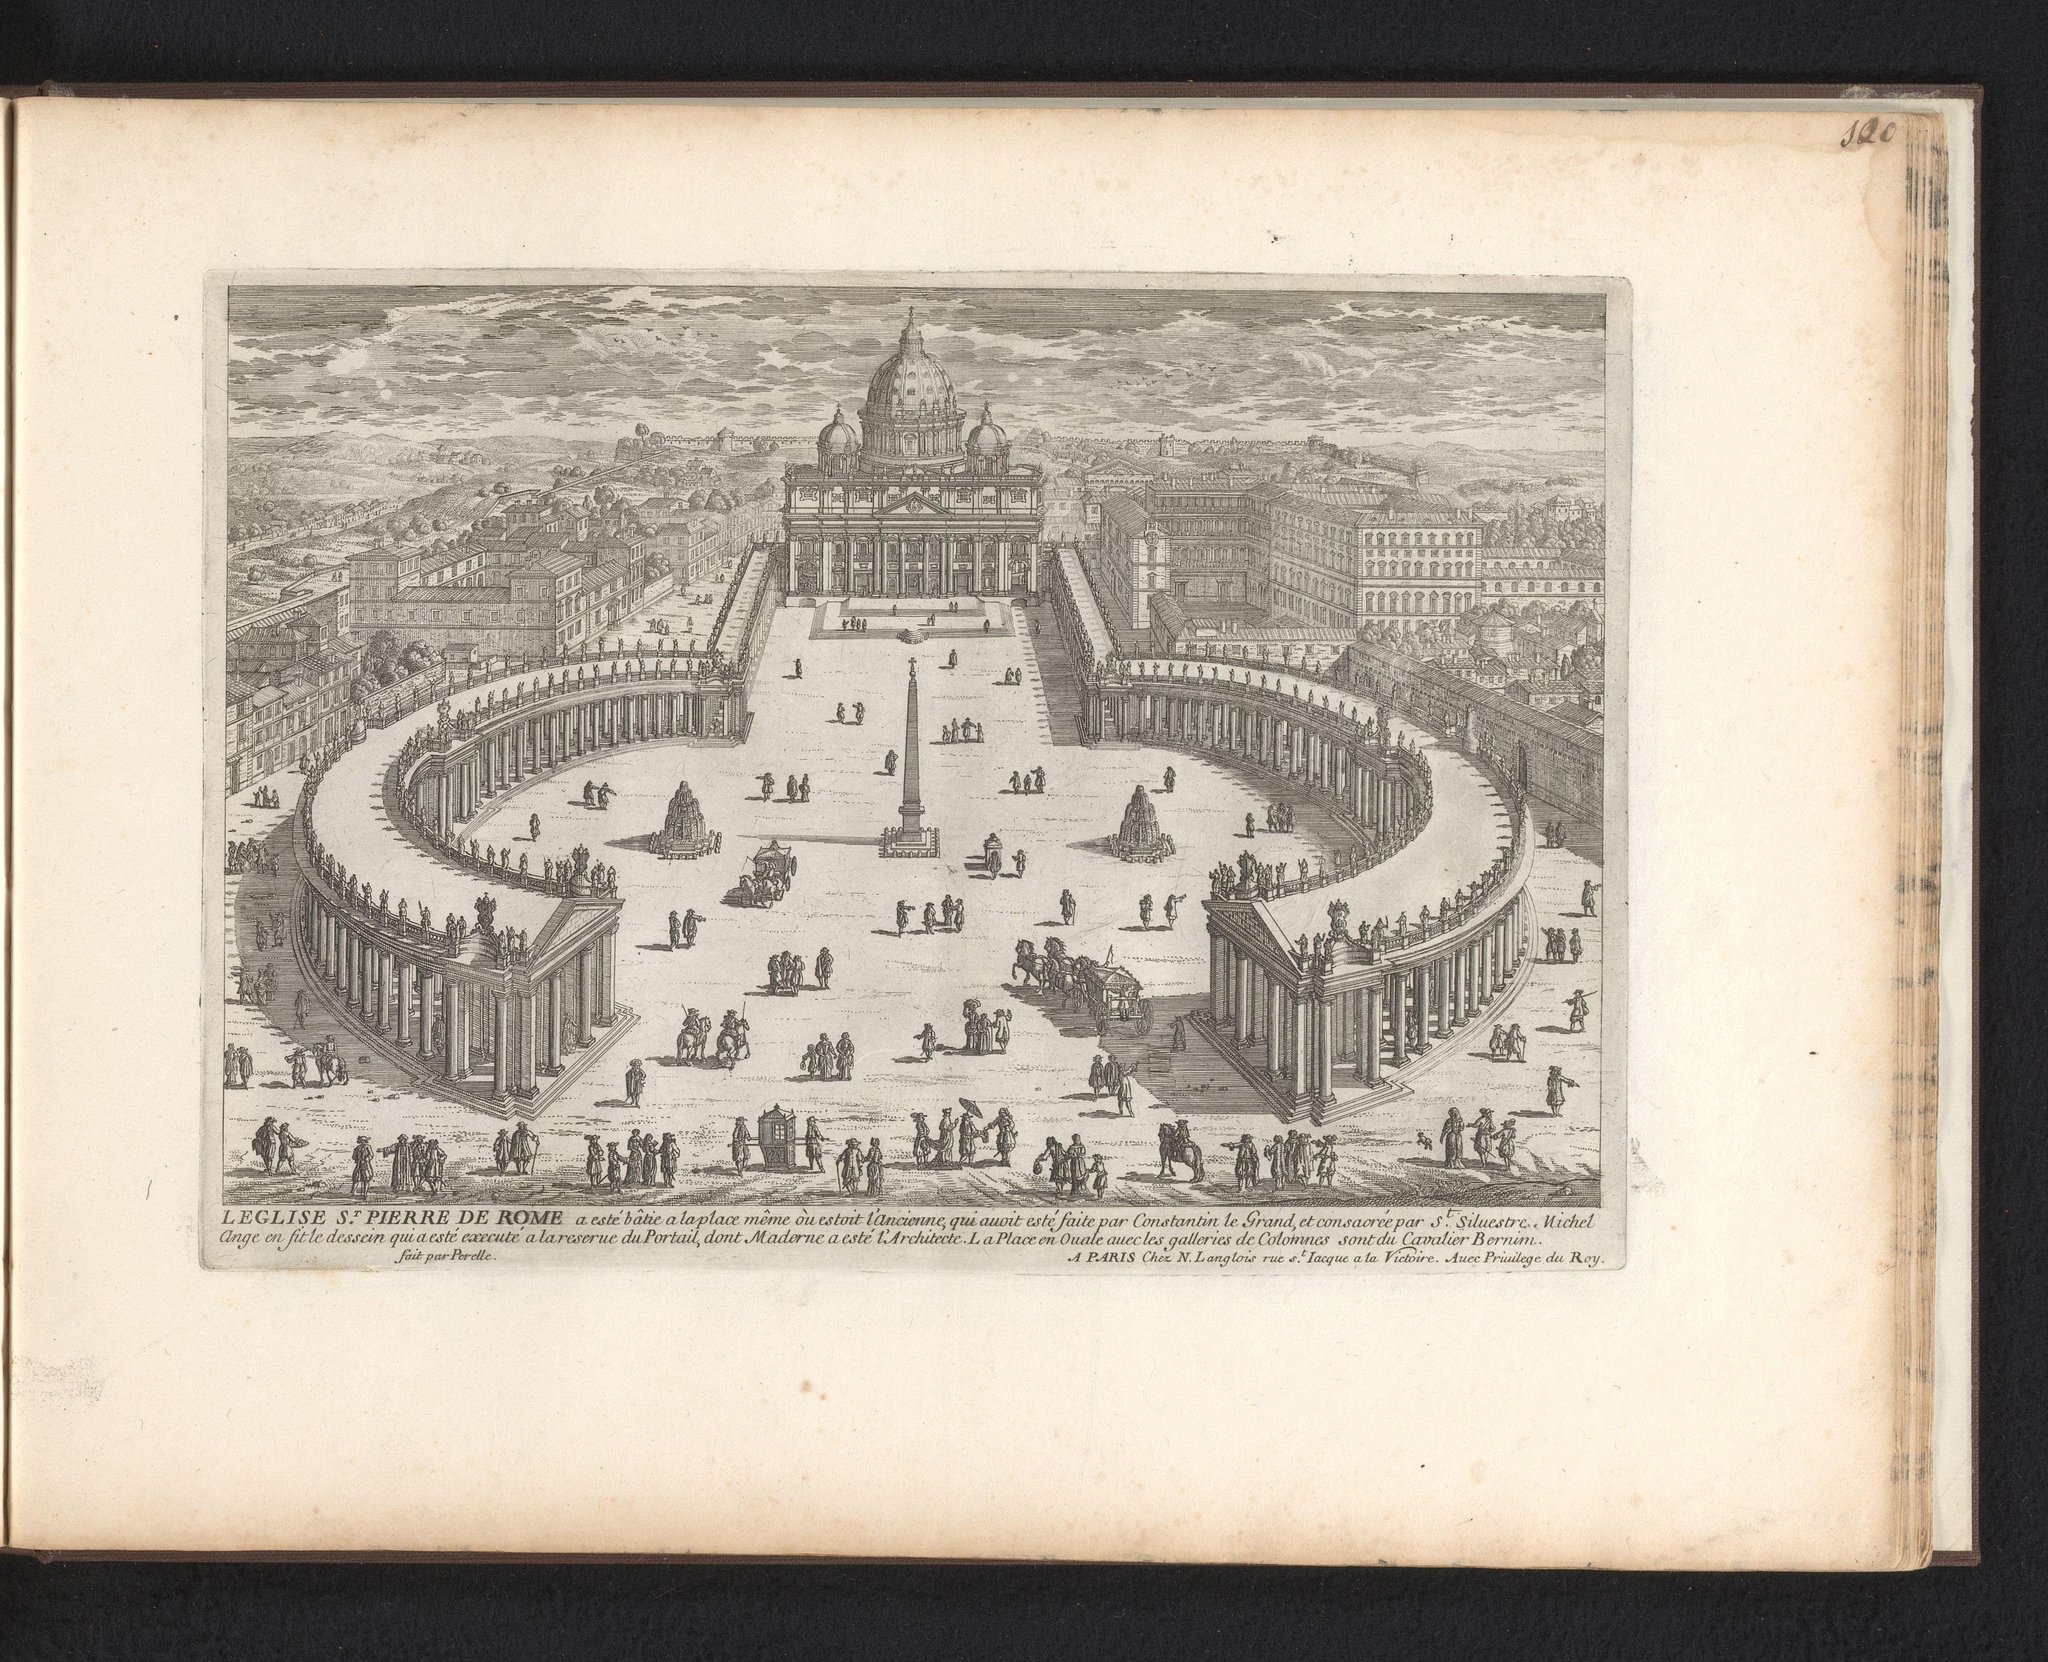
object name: album leaf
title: Stadsgezichten en landschappen in Frankrijk en Italië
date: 1650-1695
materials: paper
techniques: etching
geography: paris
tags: city-view in general; 'veduta', church (exterior)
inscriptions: collector's mark: Lugt 2228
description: Prenten met het signatuur 'Perelle' kunnen zowel door vader Gabriel als door zonen Nicolas en Adam gemaakt zijn. De uitgevers vader en zoon Nicolas Langlois worden allebei vermeld als N. Langlois op hetzelfde adres.